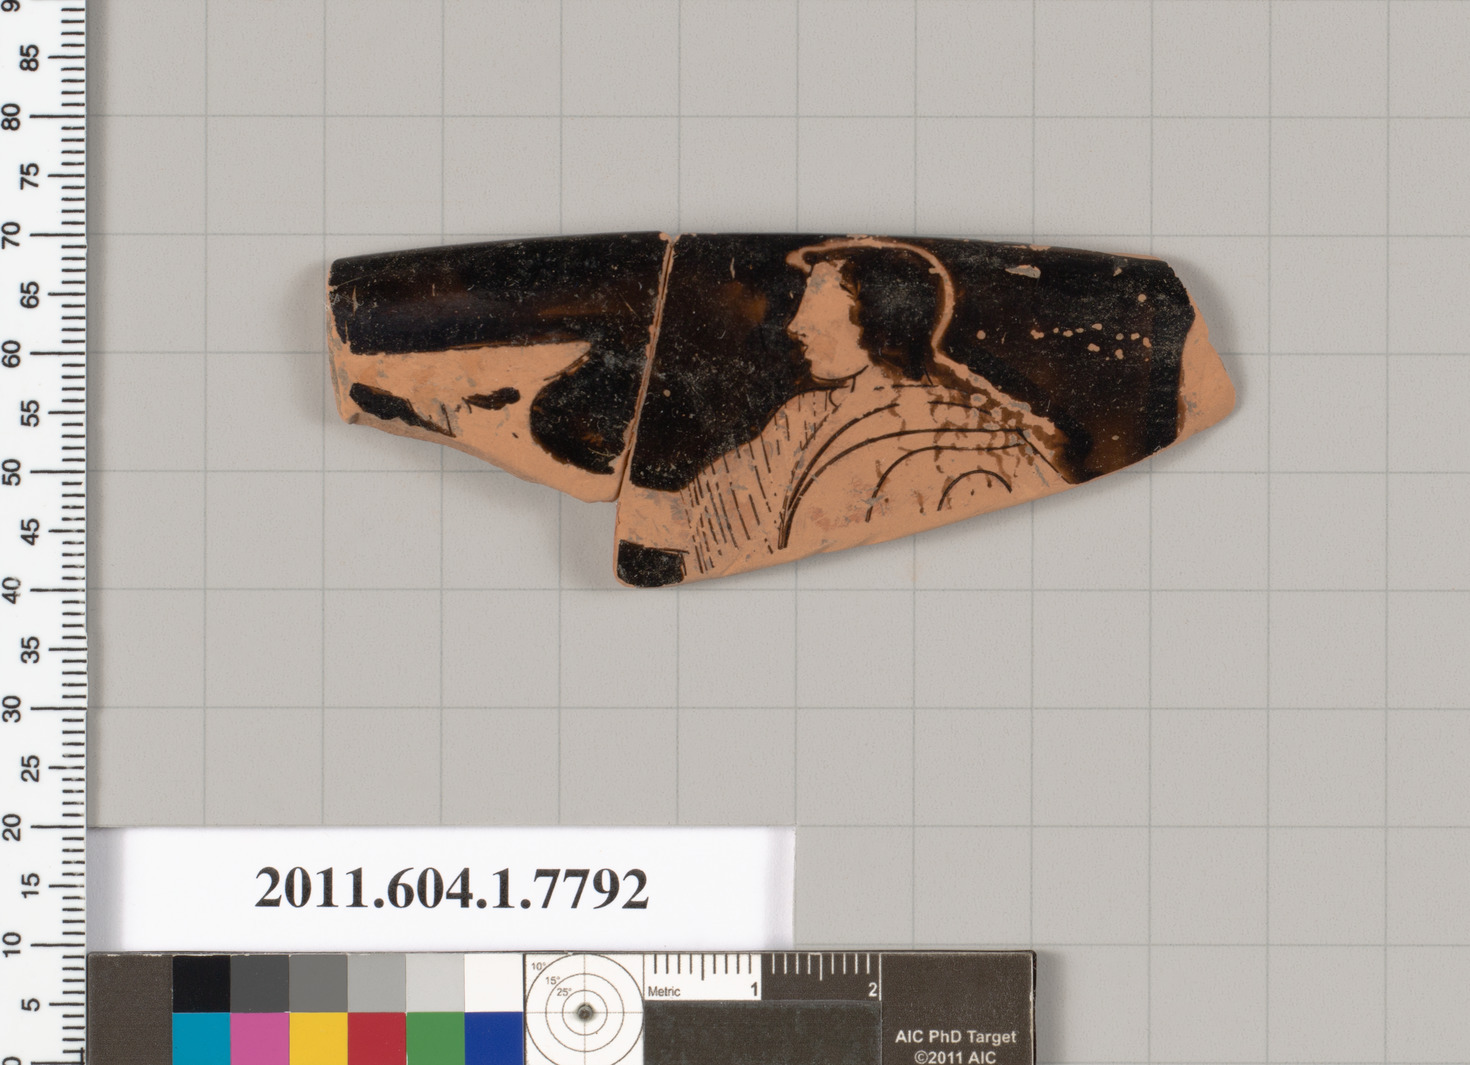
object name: kylix fragment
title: Terracotta rim fragment of a kylix (drinking cup)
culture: greek, attic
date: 460-450 BCE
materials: terracotta